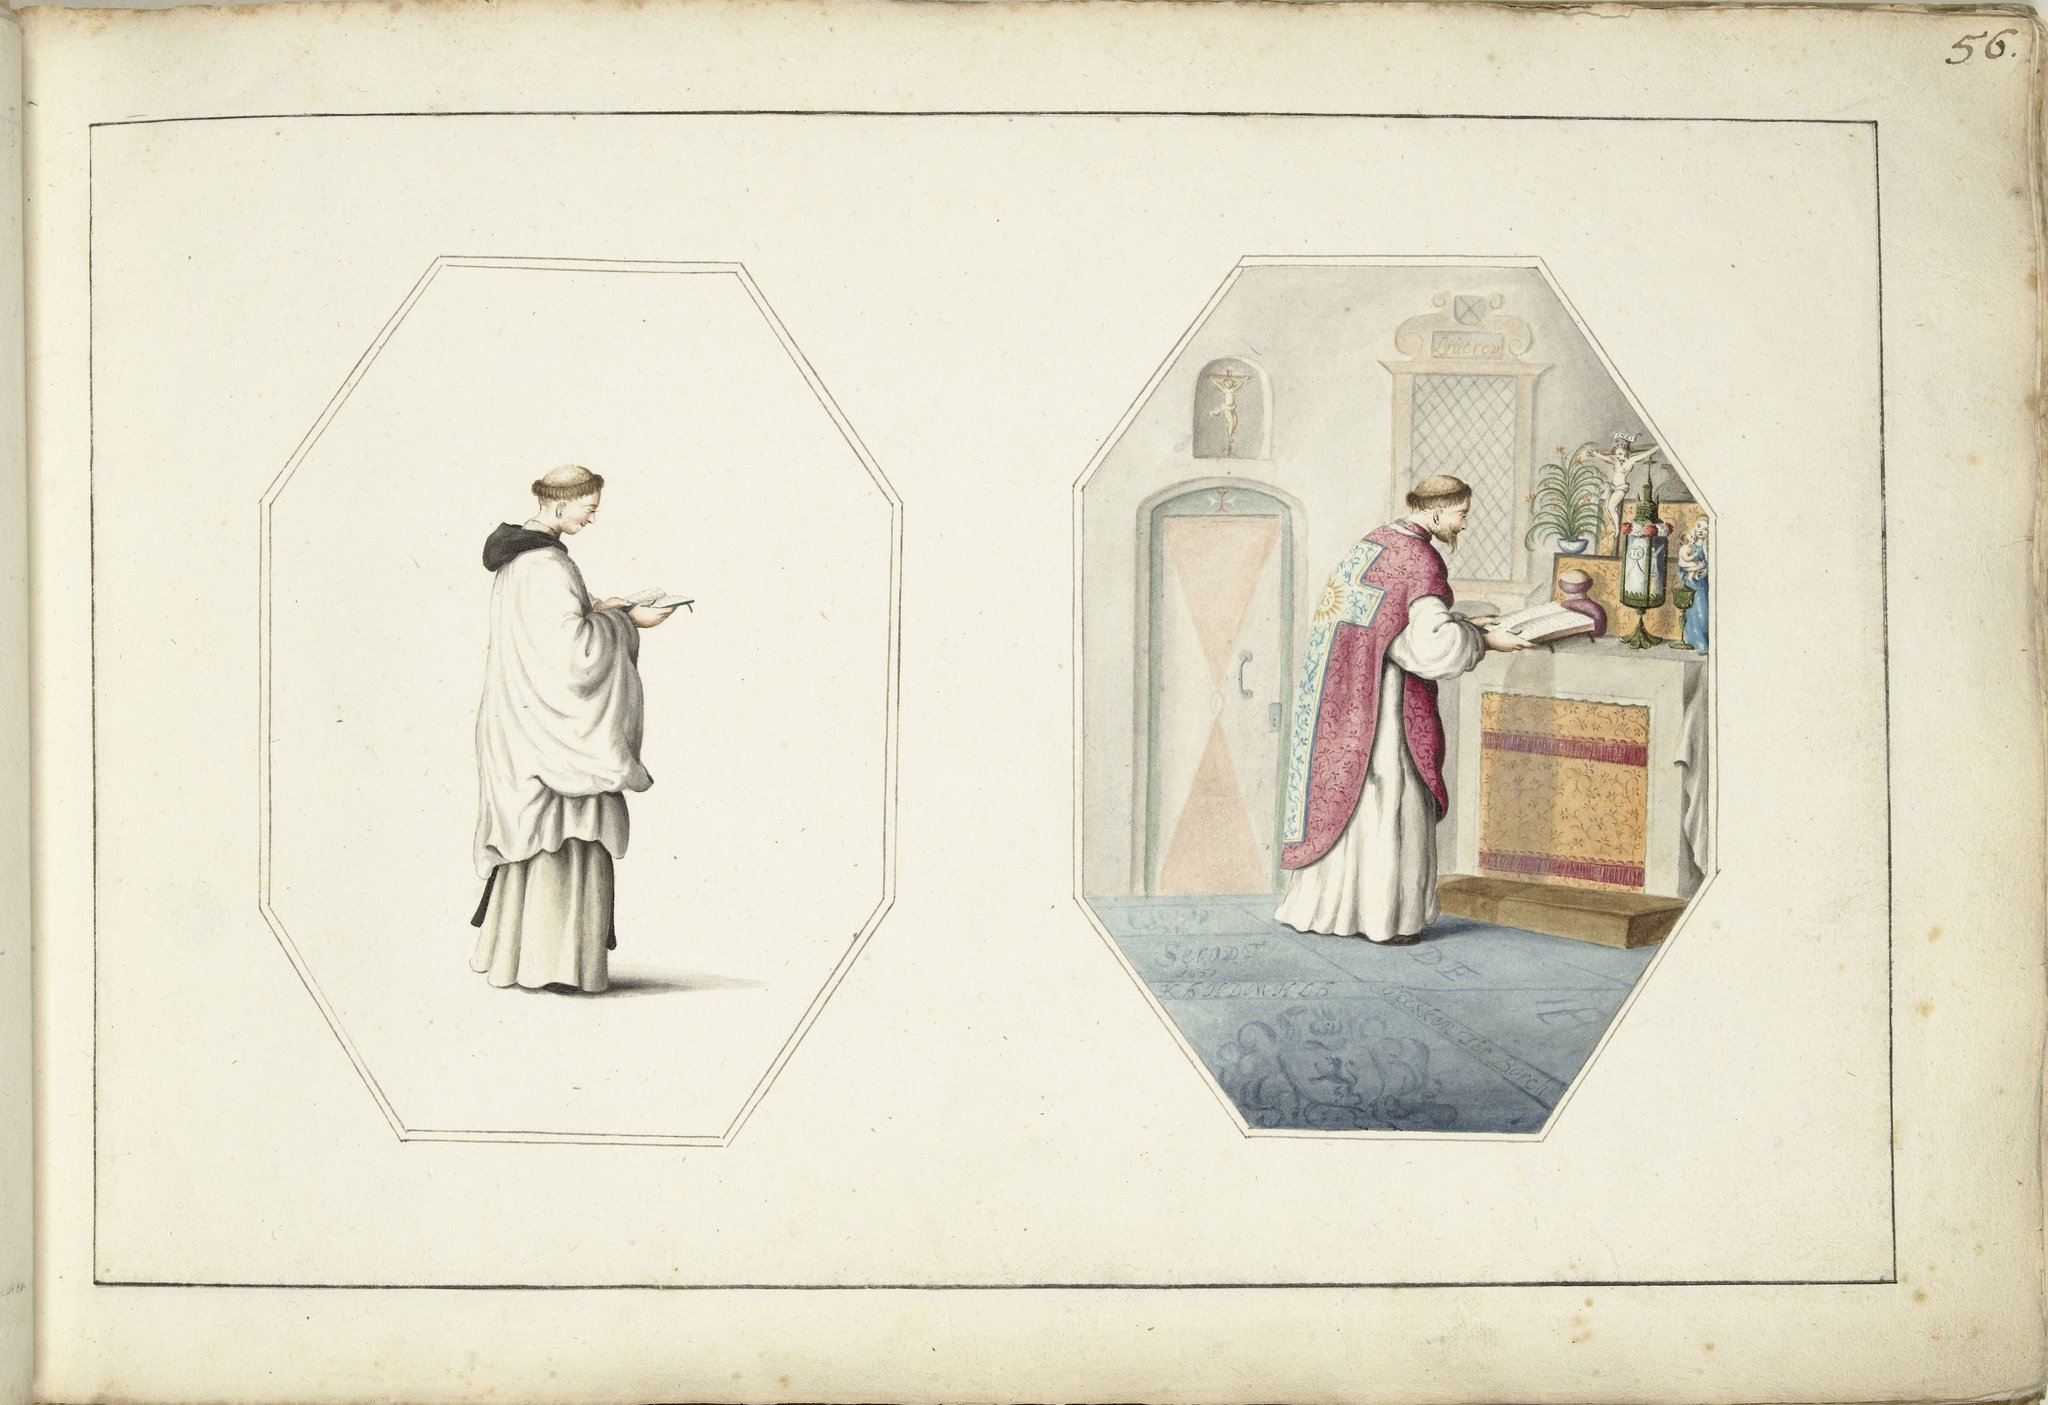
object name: drawing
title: Lezende broeder en een priester bij een altaar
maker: gesina ter borch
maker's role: draughtsman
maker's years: 1633-1690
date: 1657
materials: paper, watercolor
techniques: brush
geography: zwolle